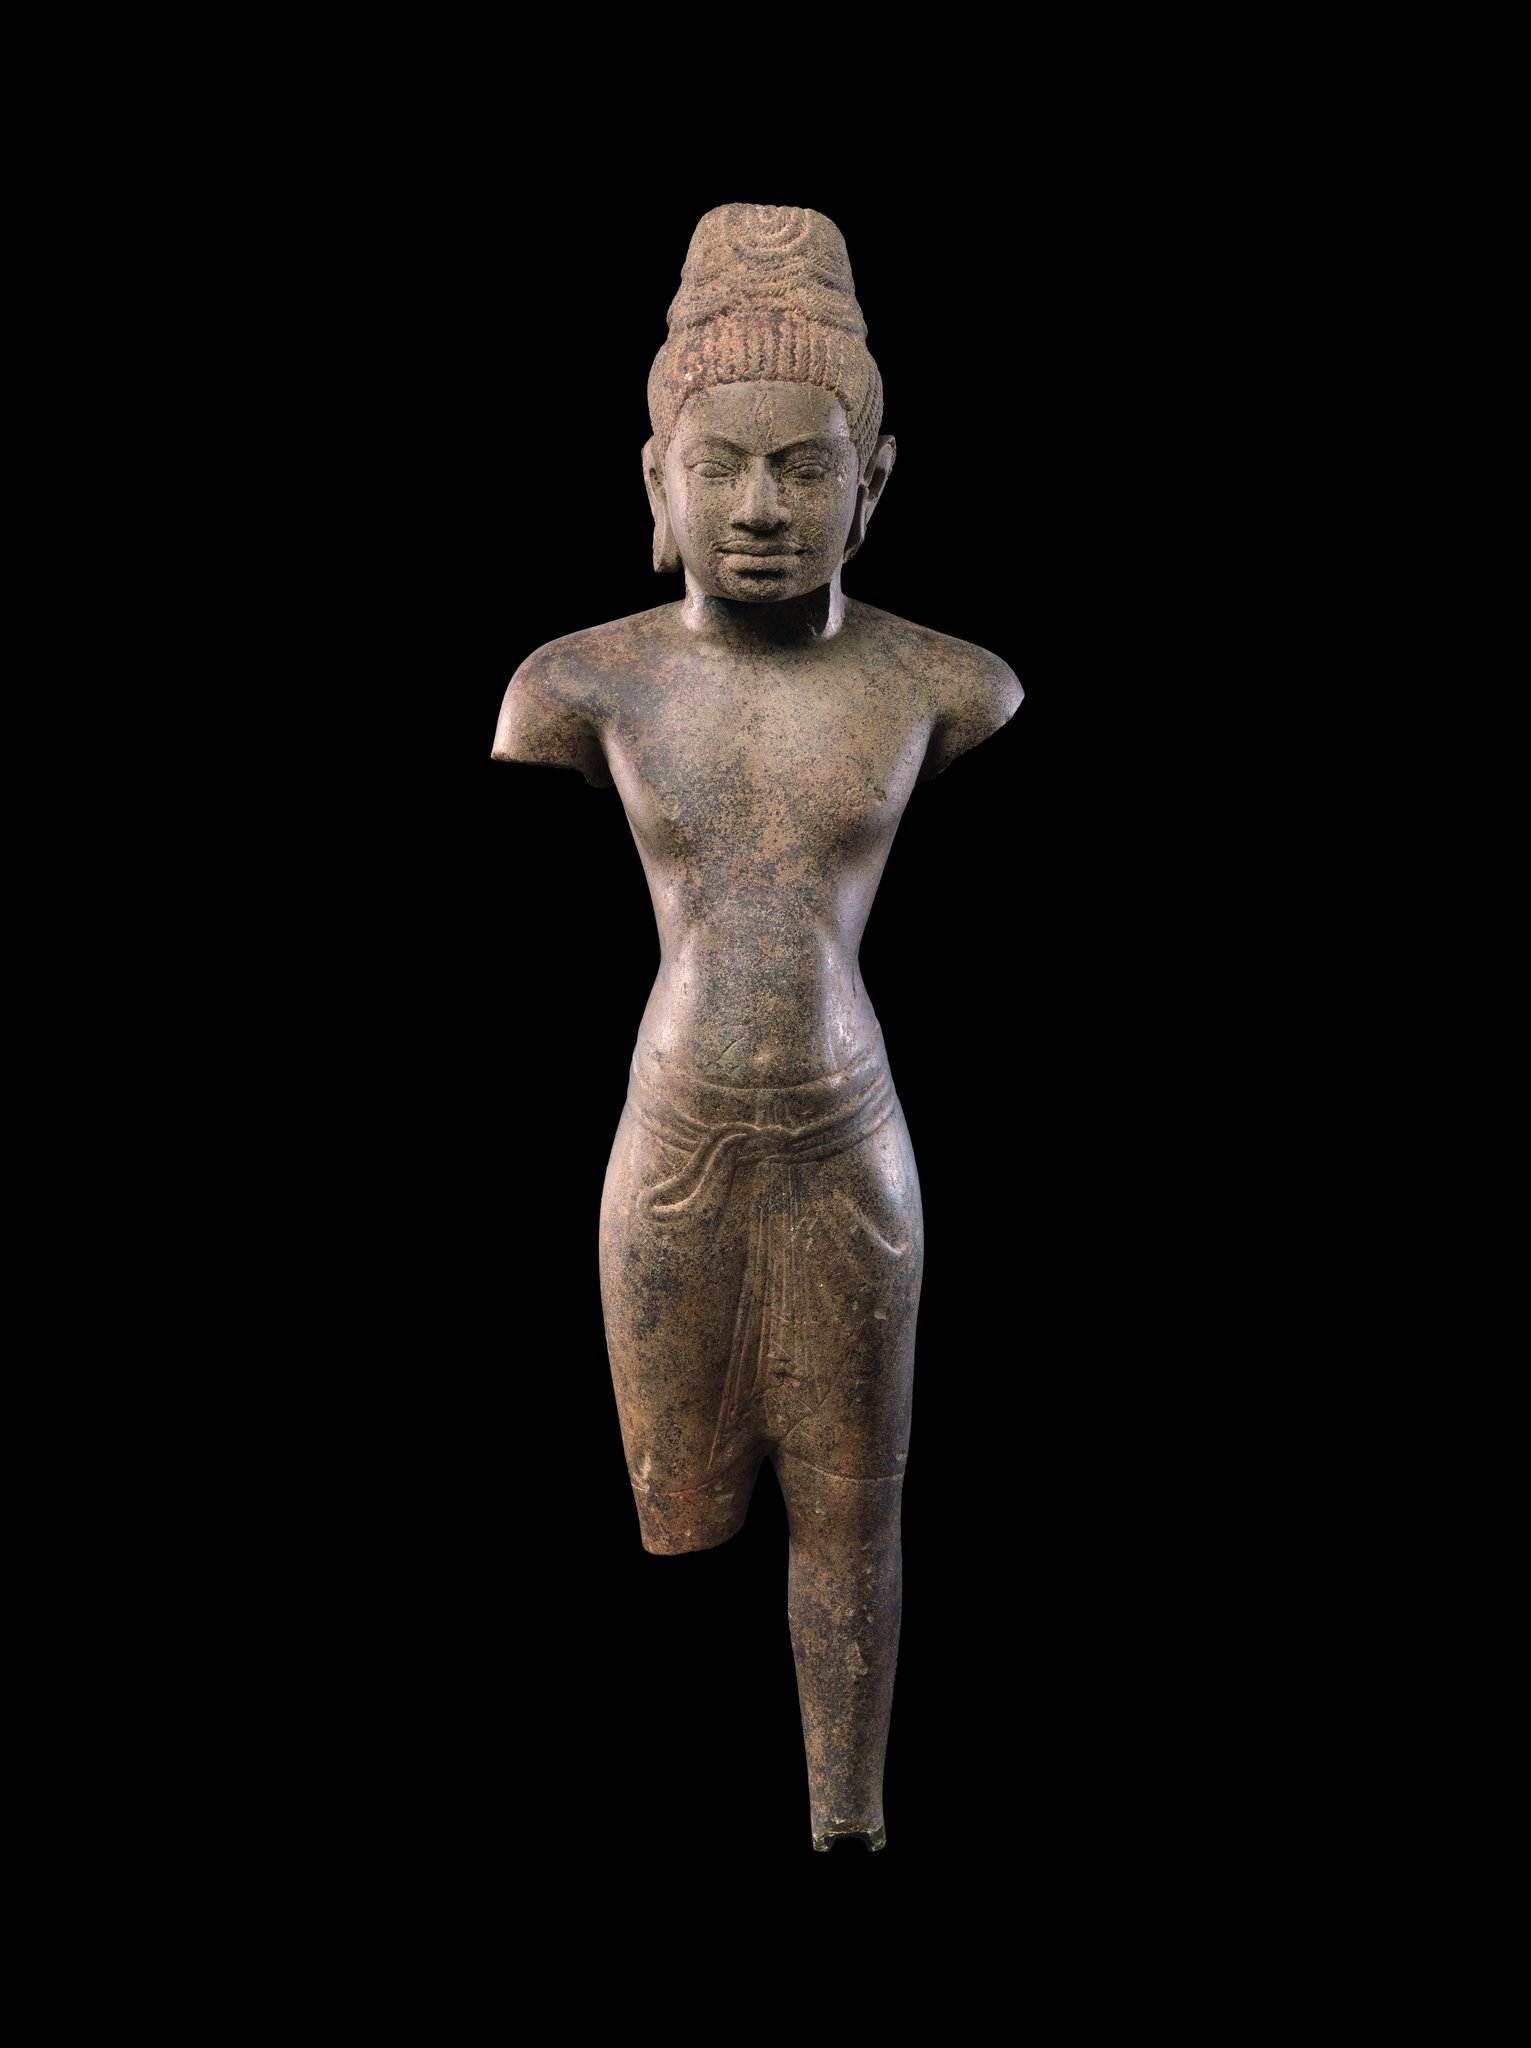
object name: figure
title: Shiva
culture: vietnamese or cambodian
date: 634-666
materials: stone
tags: shiva,hinduism